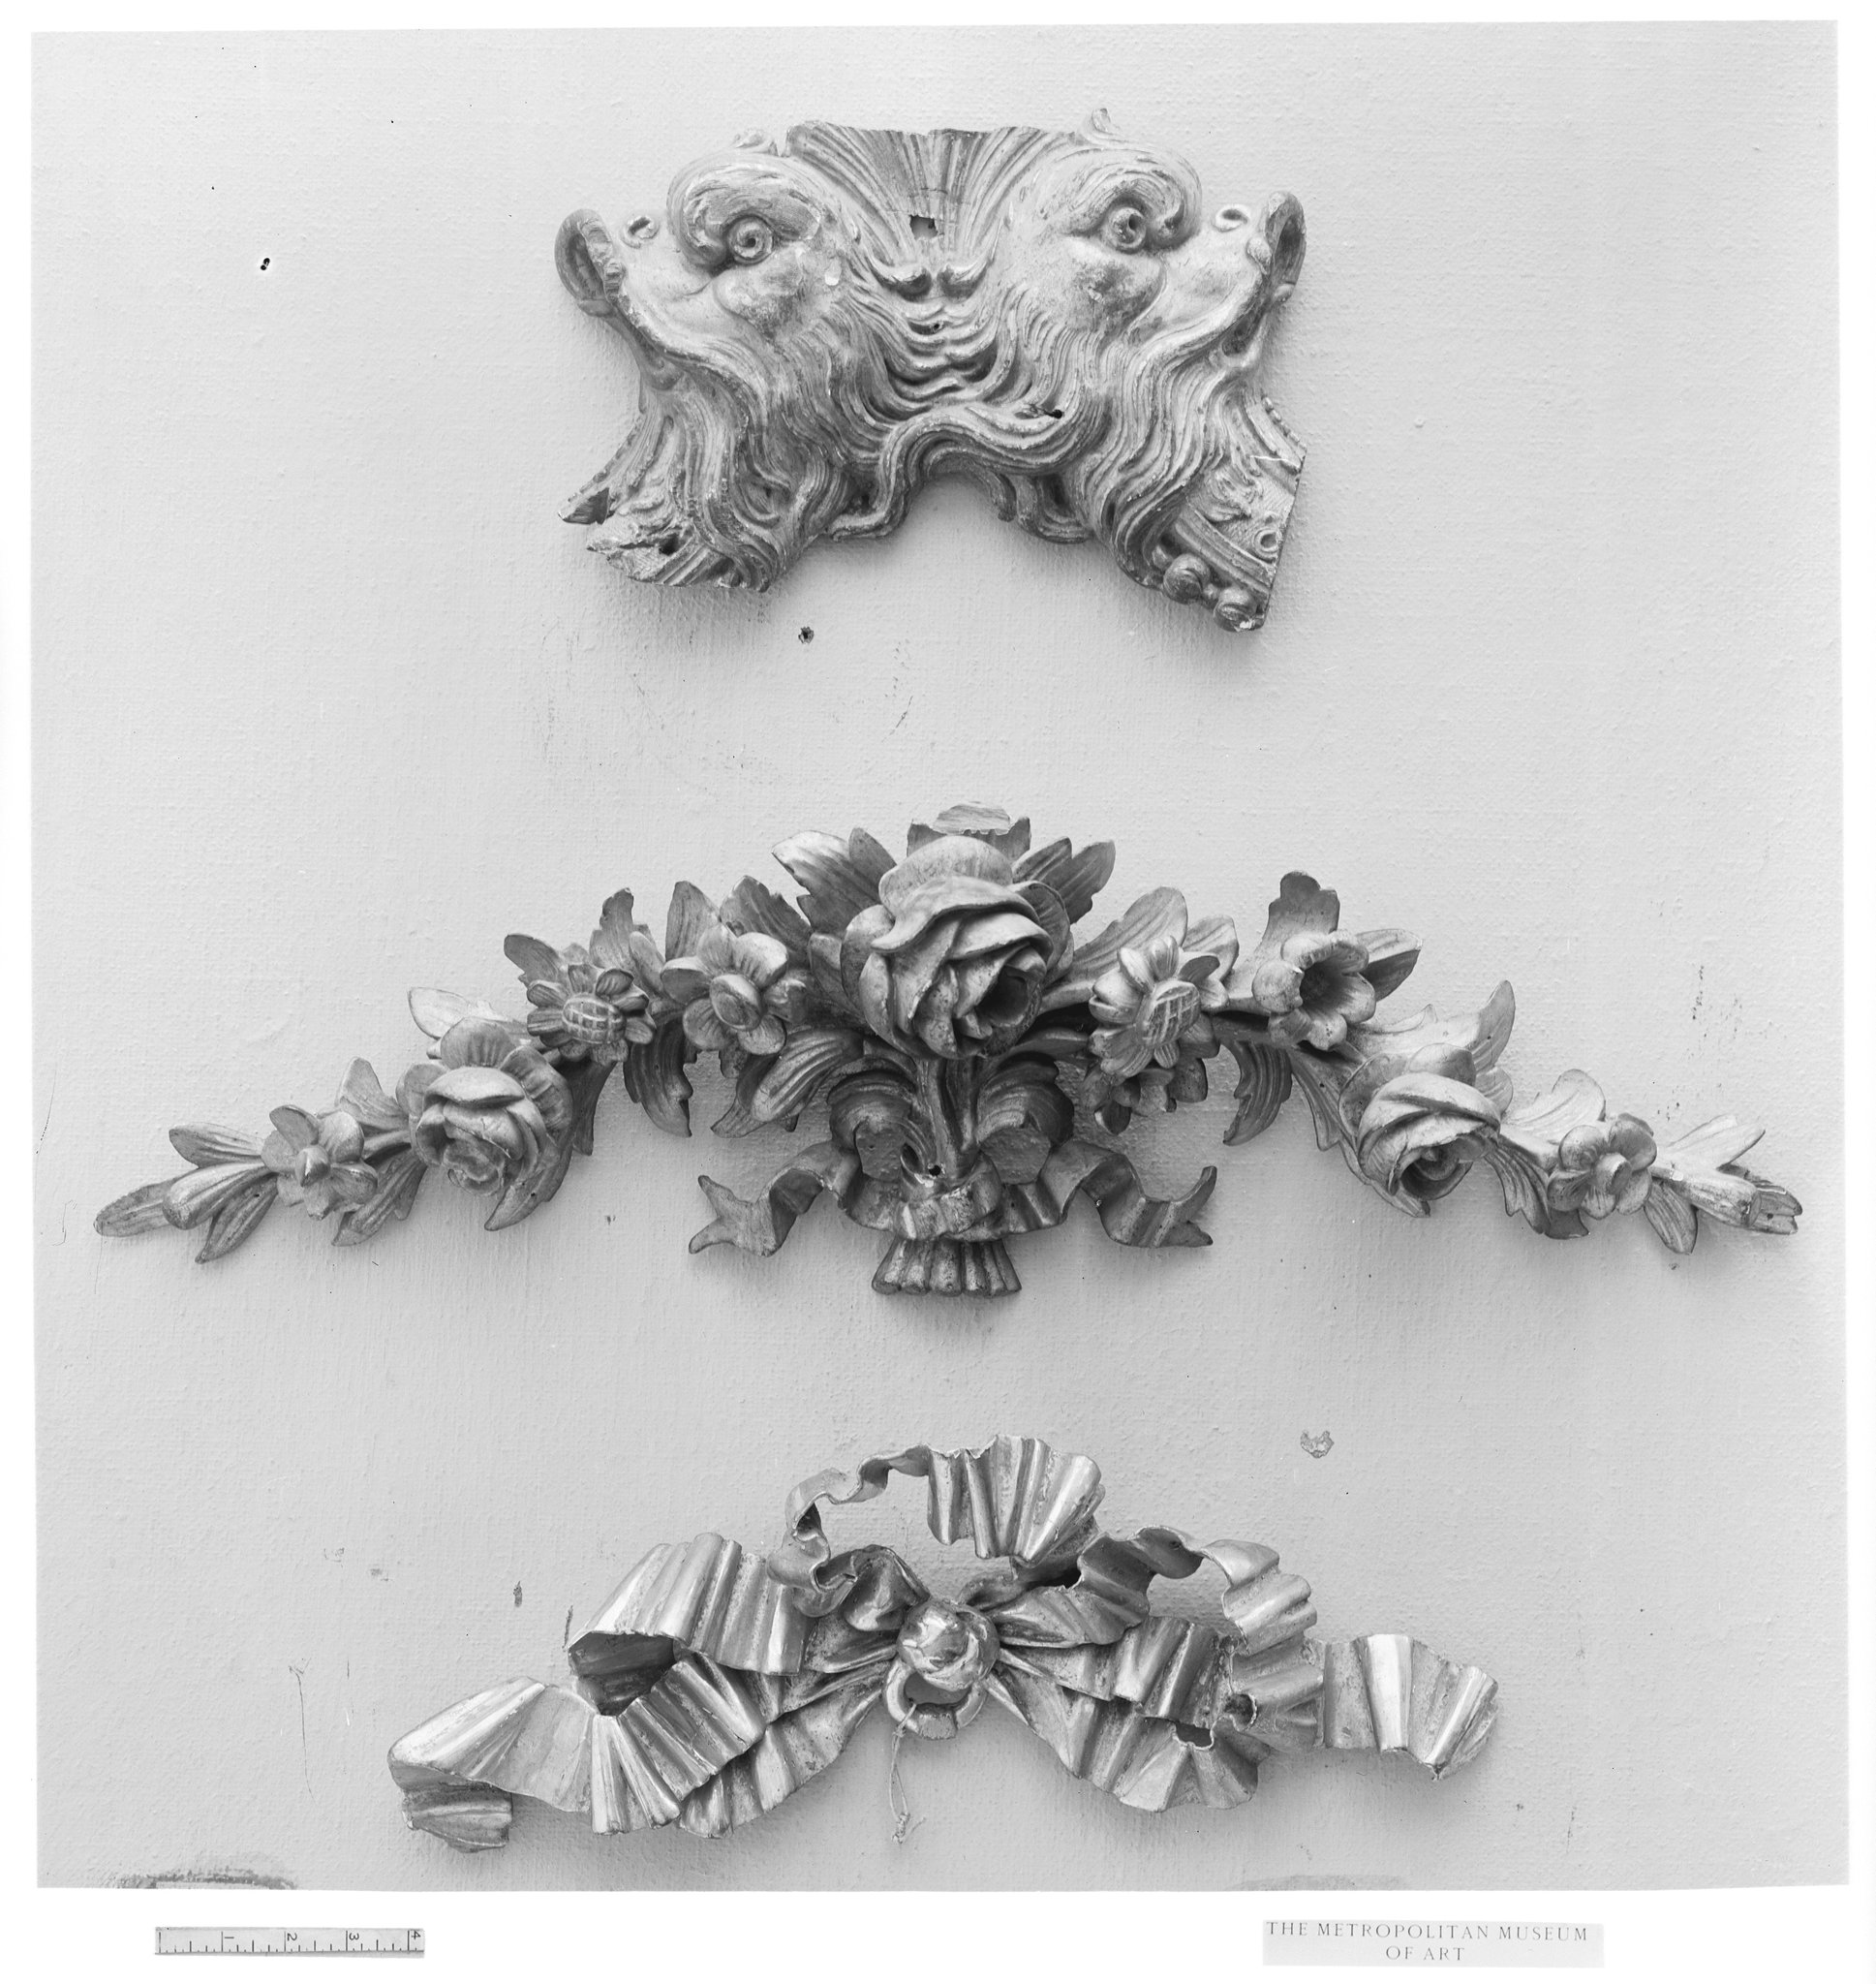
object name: garland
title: Garland (detail of fronton)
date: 1701-1800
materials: gilt, wood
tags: garlands,flowers,leaves